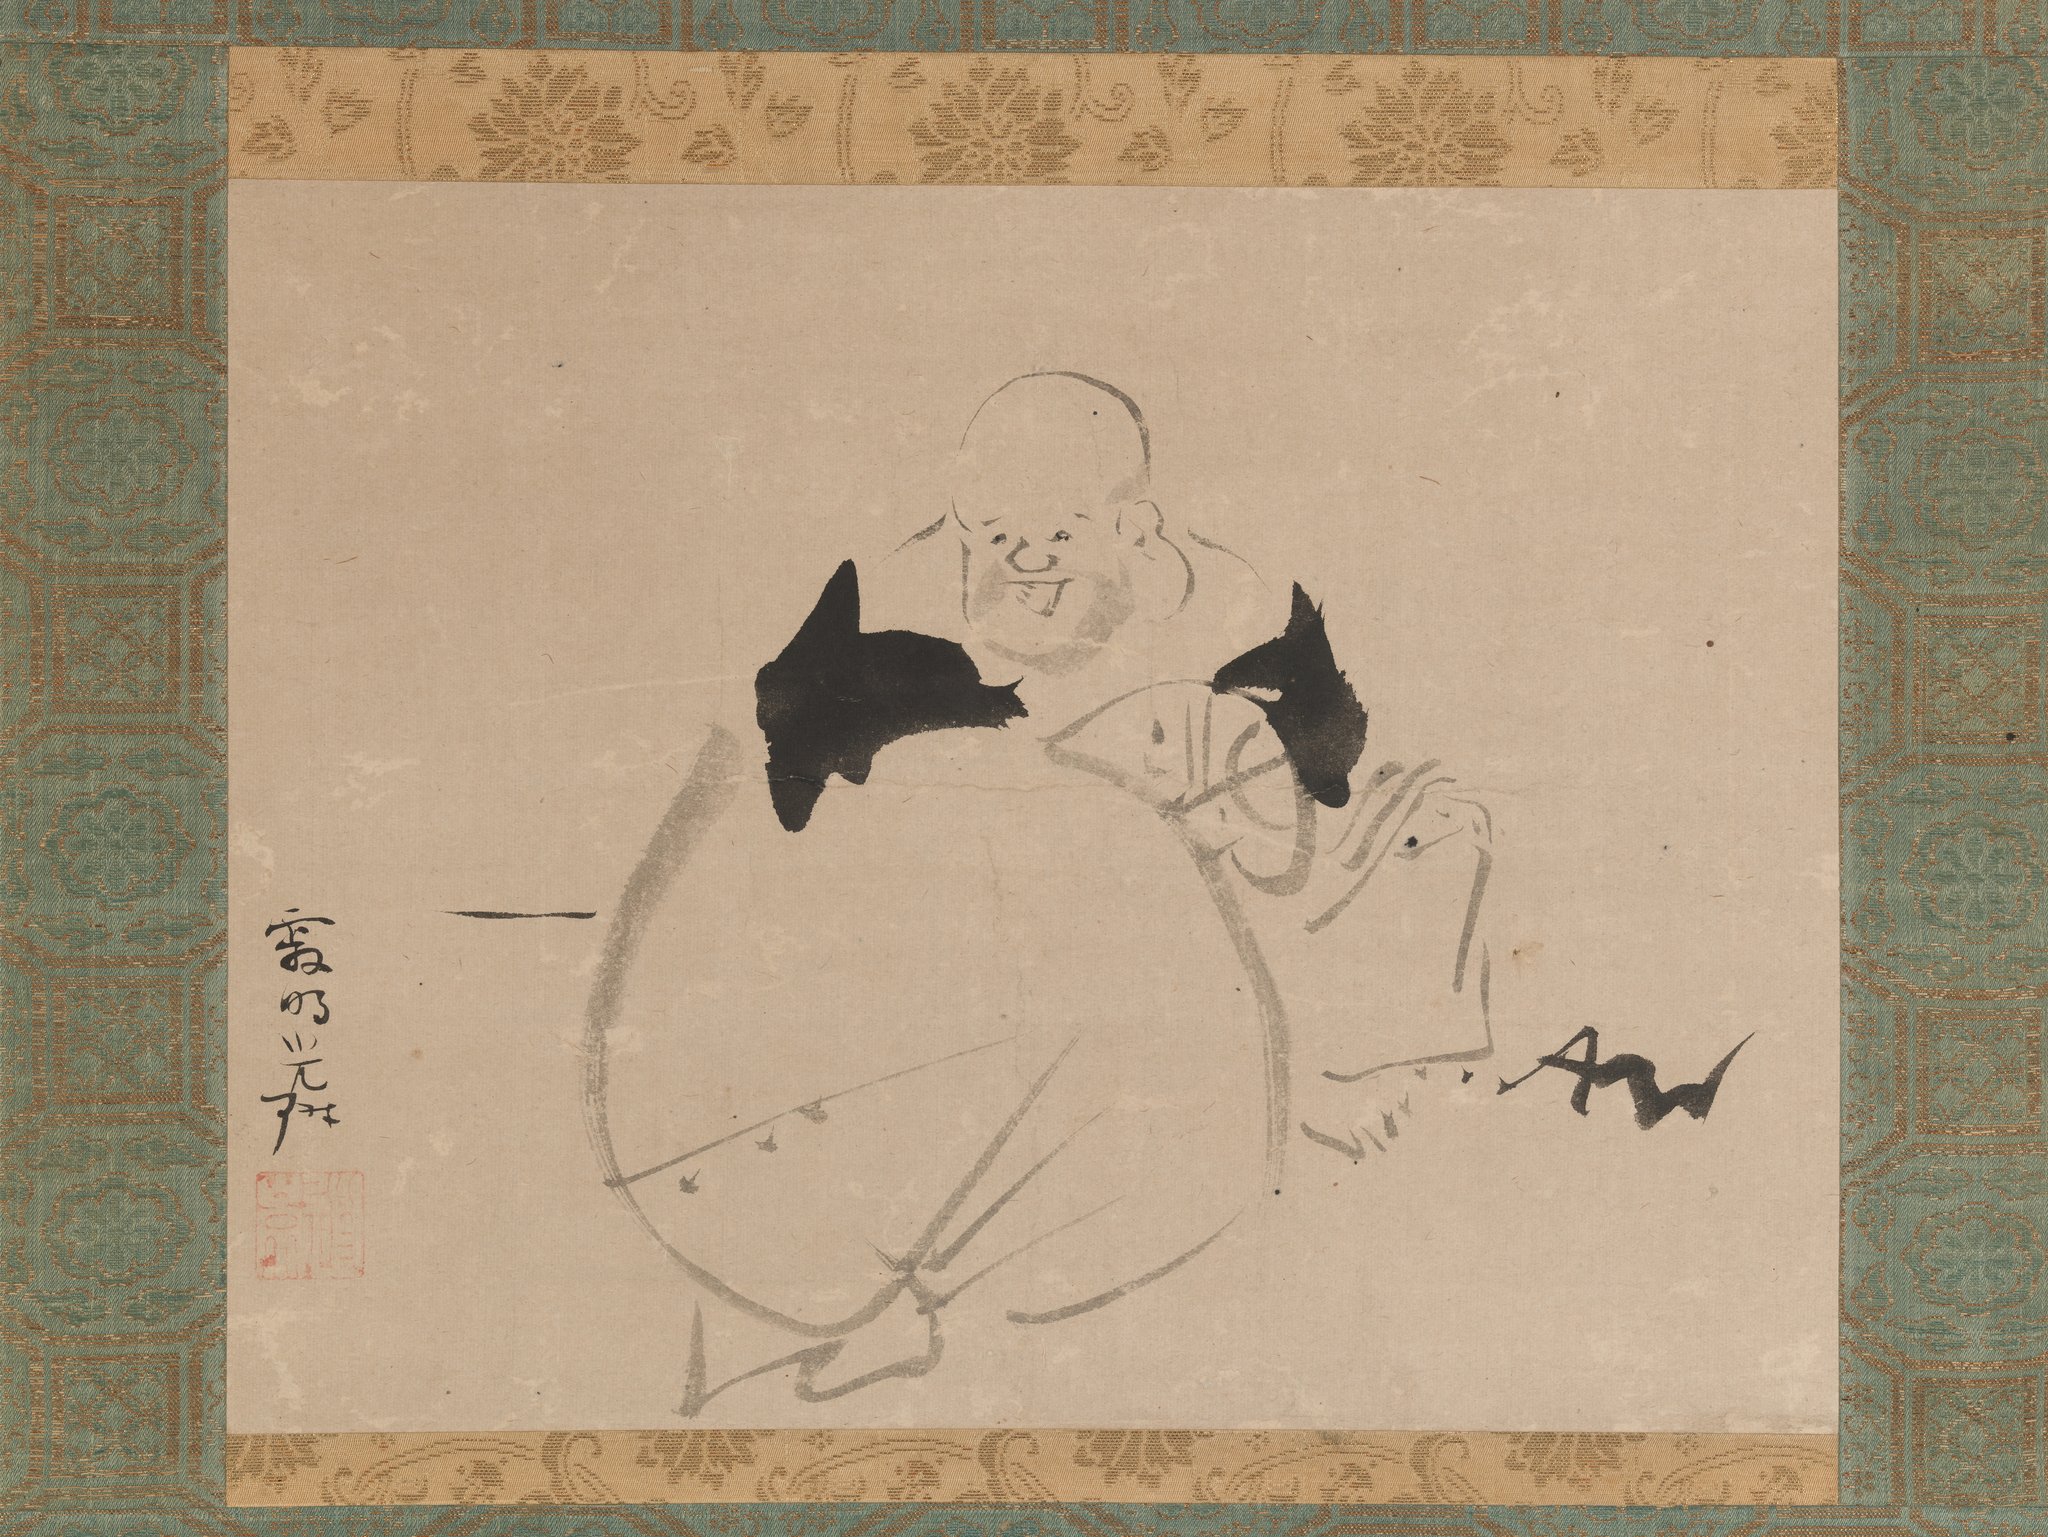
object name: hanging scroll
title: Hotei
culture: japanese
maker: ogata kōrin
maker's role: artist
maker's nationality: japanese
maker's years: 1658-1716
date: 1704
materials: ink, paper